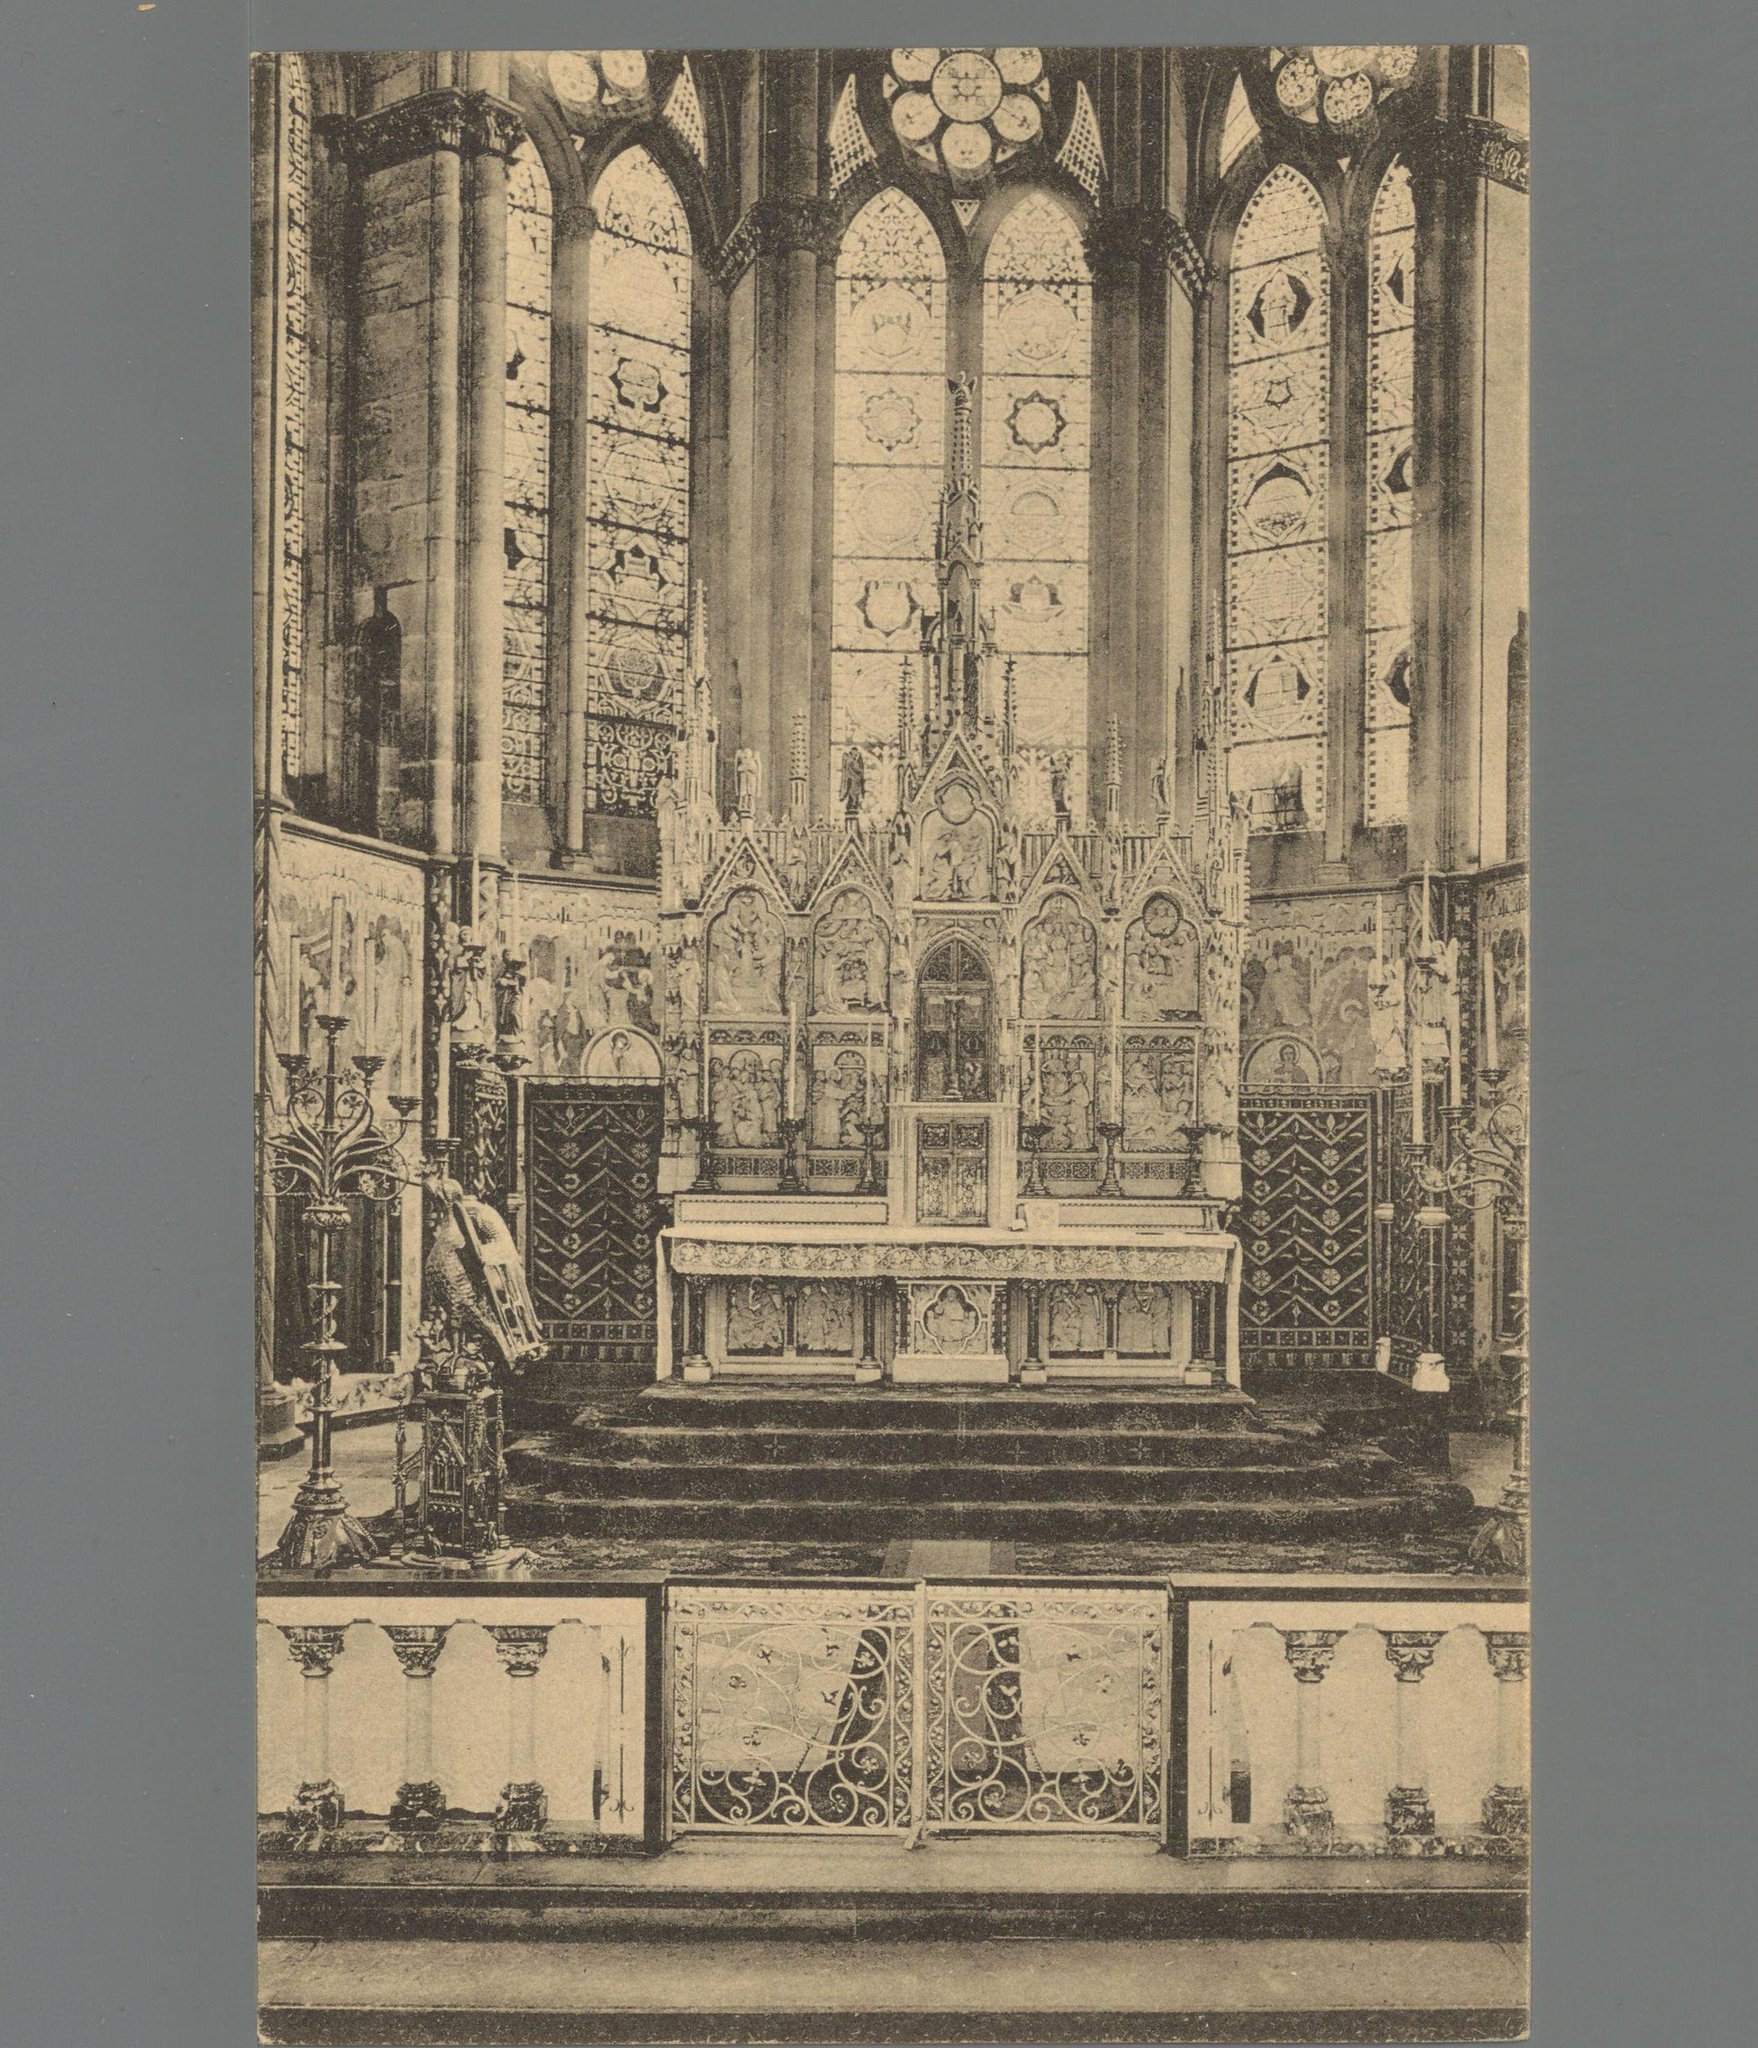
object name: photomechanical print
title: Trier. Liebfrauenkirche. Hochaltar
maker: Anonymous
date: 1905-1930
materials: cardboard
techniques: photograph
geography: trier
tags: interior of church, altar with altar-piece